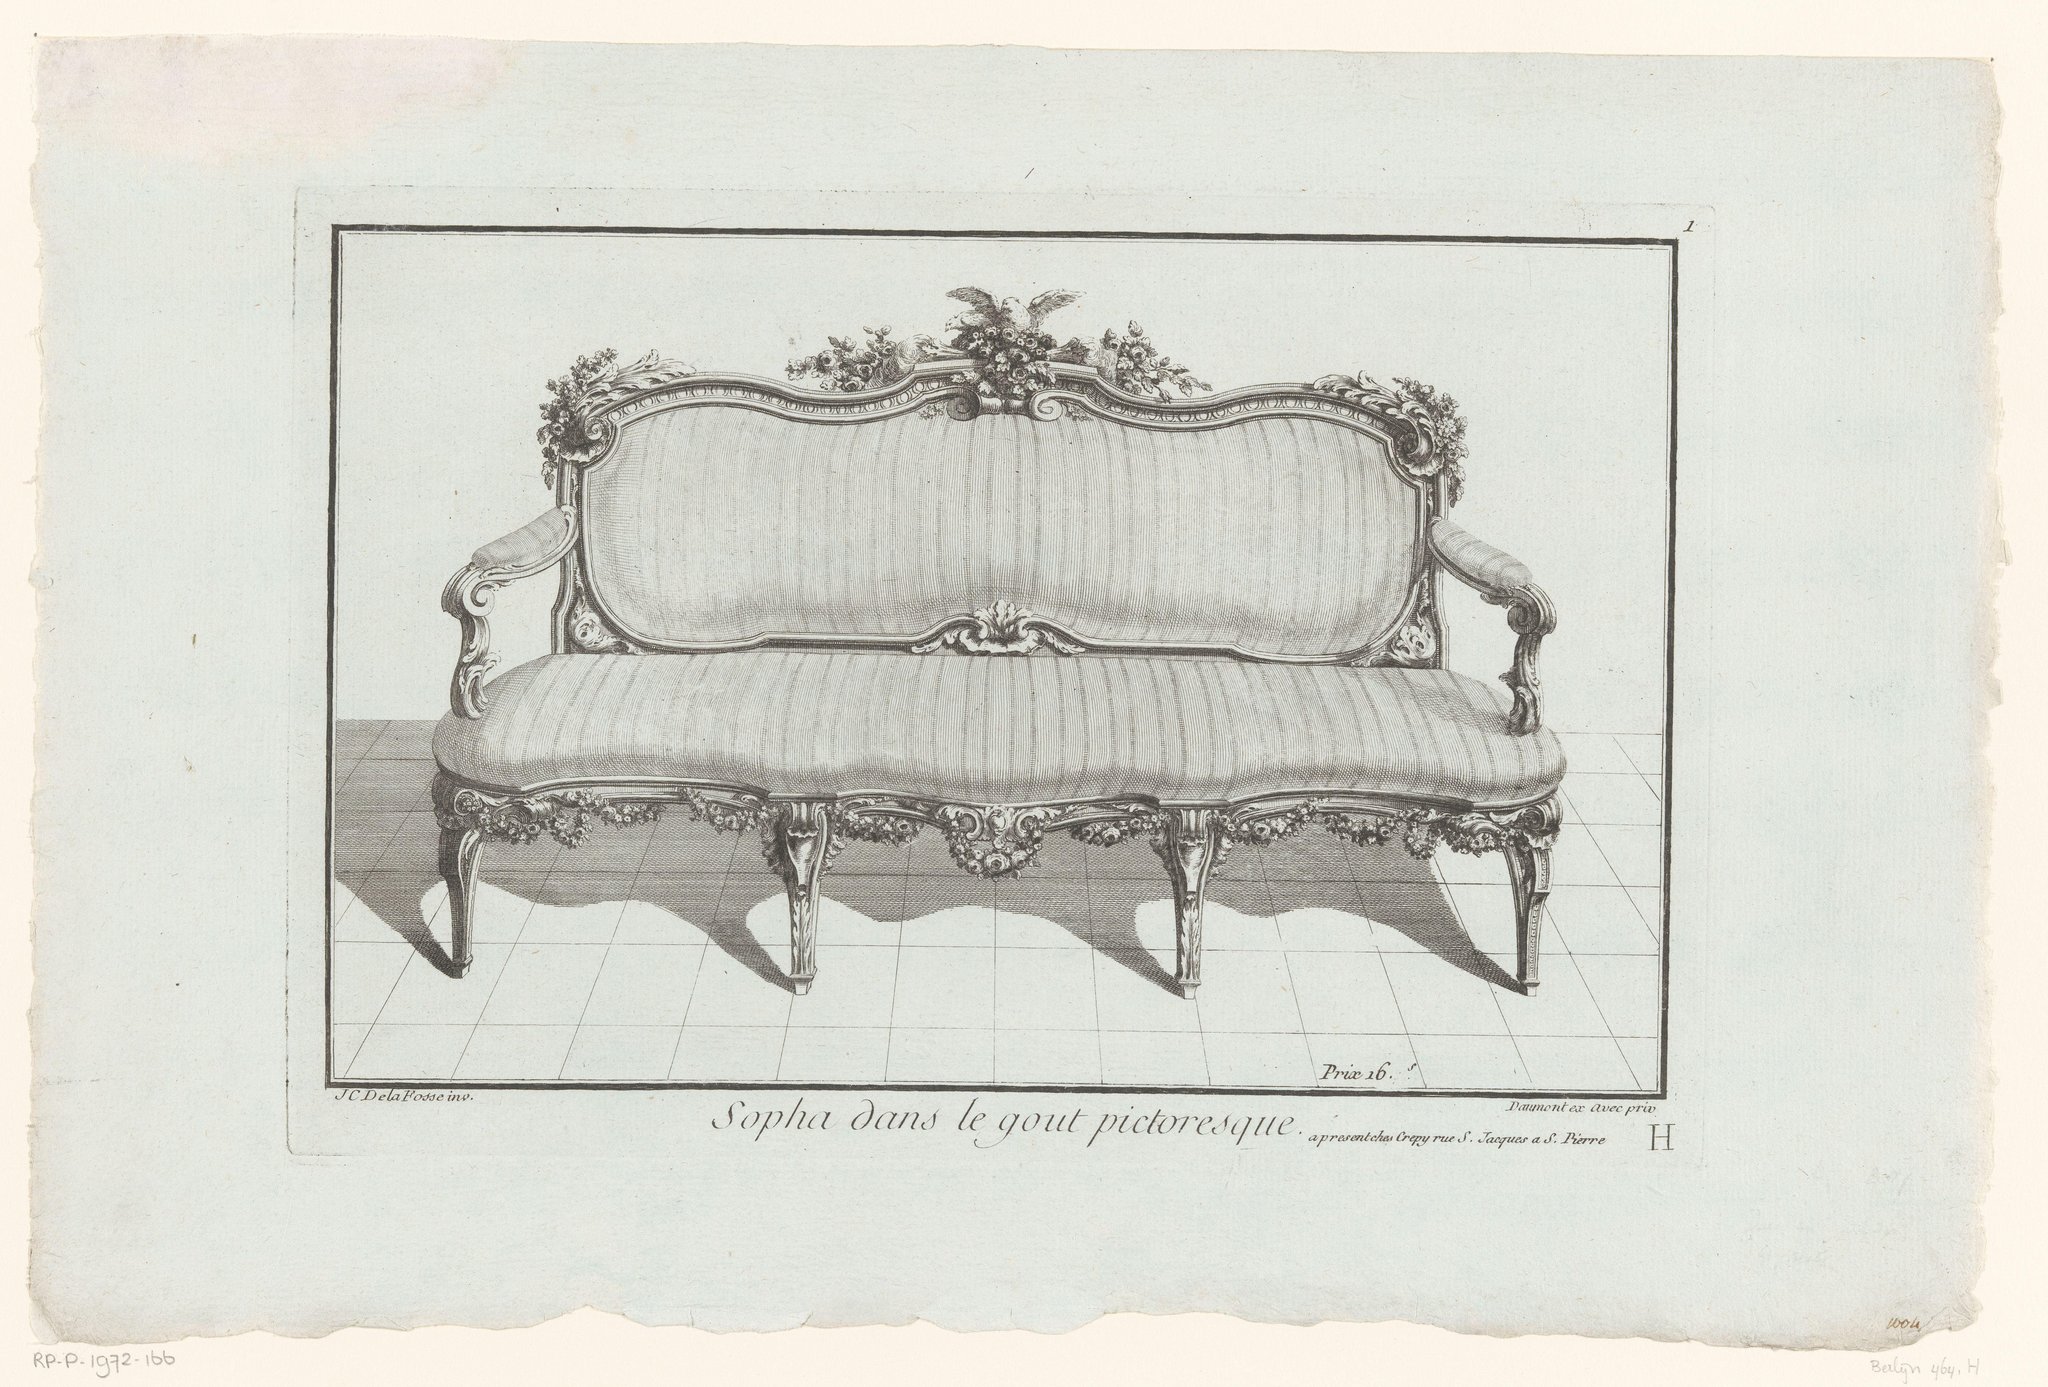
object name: ornament print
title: Bank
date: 1753-1775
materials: paper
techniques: engraving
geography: paris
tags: bench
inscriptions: collector's mark: Lugt 2228, collector's mark: Lugt 2760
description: Een bank met armleuningen en gestreepte bekleding, geornamenteerd met guirlandes, fakkels en twee duiven.